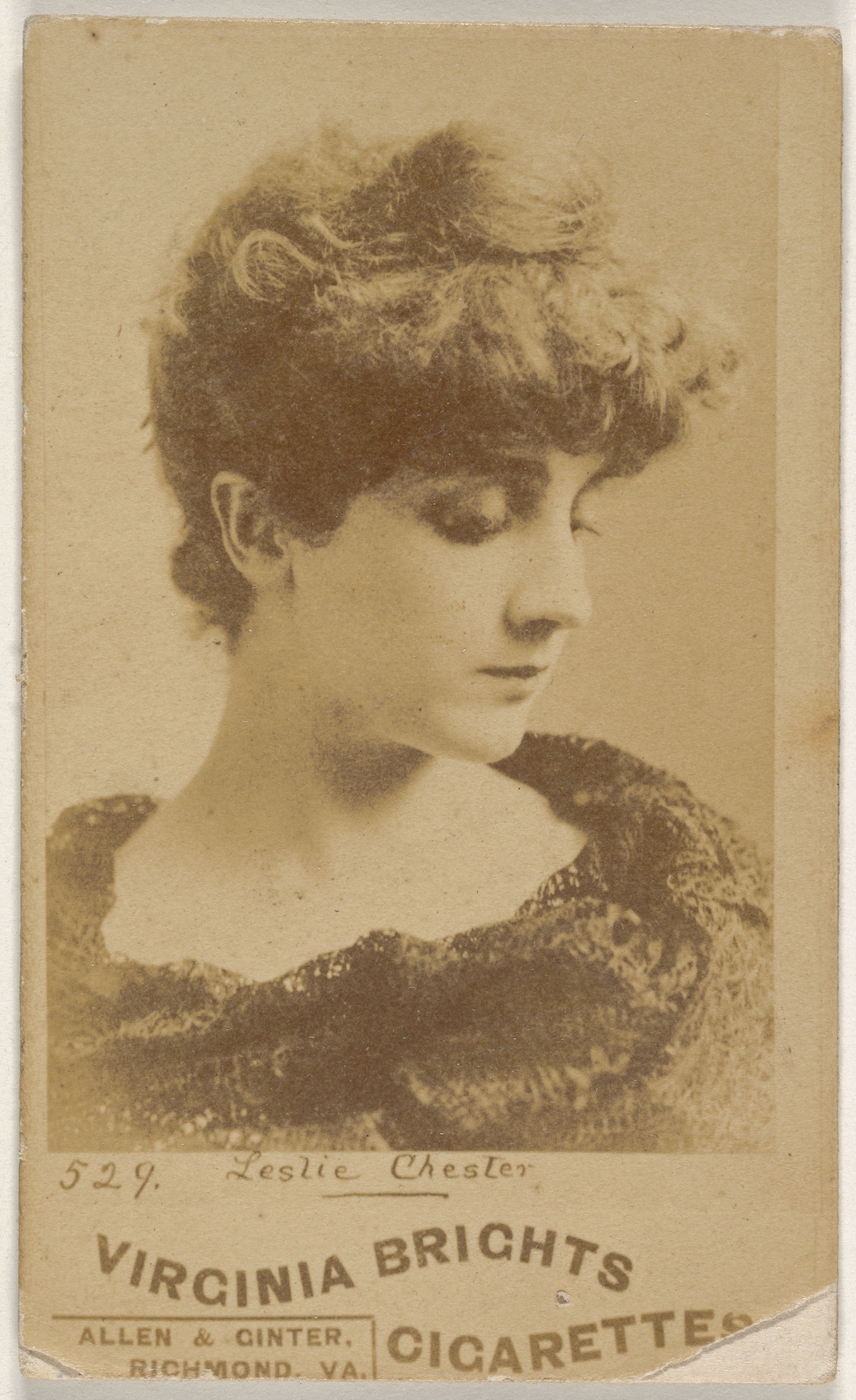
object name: photograph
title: Card 529, Leslie Chester, from the Actors and Actresses series (N45, Type 6) for Virginia Brights Cigarettes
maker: allen & ginter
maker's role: publisher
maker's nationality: american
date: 1888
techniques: albumen silver print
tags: portraits,women,actresses